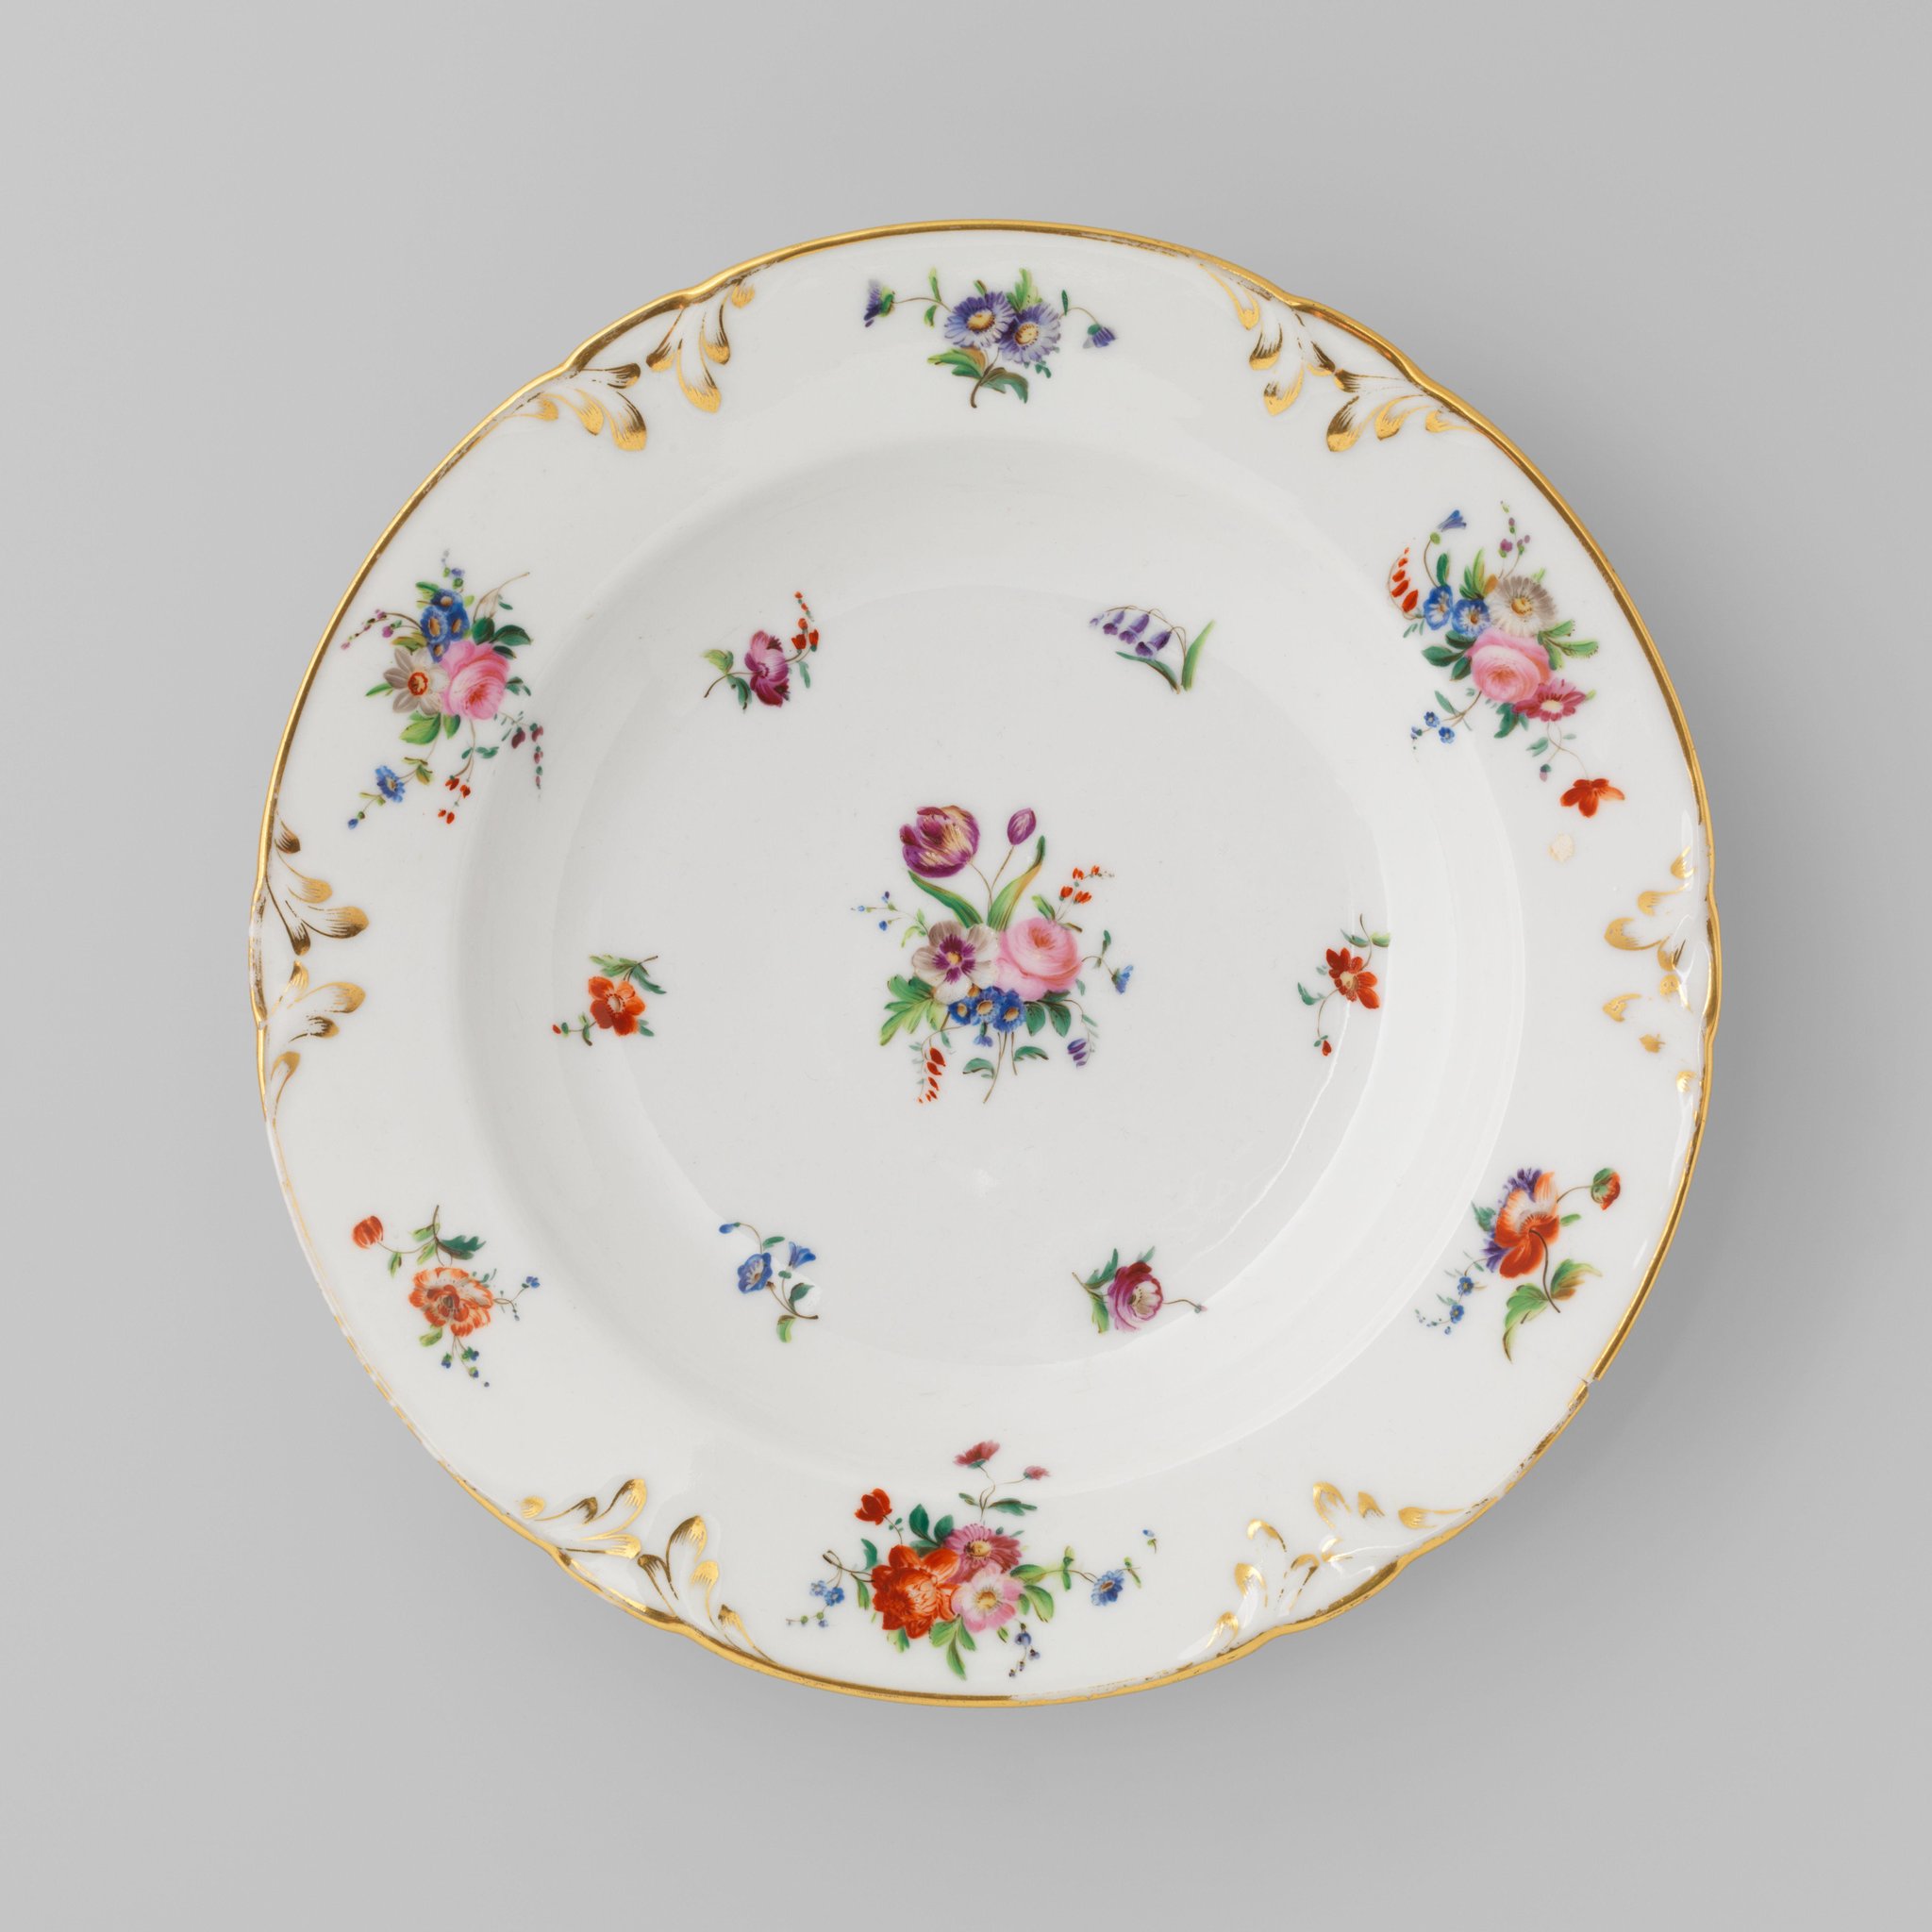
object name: service set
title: Plate with bouquets and flower sprays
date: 1839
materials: glaze, gold, paint, porcelain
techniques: firing, forming, gilding, turning, vitrification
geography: paris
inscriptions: mark: ‘DENUELLE/ Boulevard St. Denis 18/ à Paris’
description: Diep bord van porselein met een gelobde rand, beschilderd op het glazuur in blauw, rood, roze, groen, geel, paars, zwart en goud. Op het plat boeketten van verschillende bloemen en strooibloemen. Vanuit de gelobde, gouden rand, gemodelleerde bladranken in reliëf, aangezet met goud. Hiertussen boeketten. Drie proenen op de onderzijde. Gemerkt op de onderzijde met 'DENUELLE/ Boulevard St. Denis 18/ à Paris'.